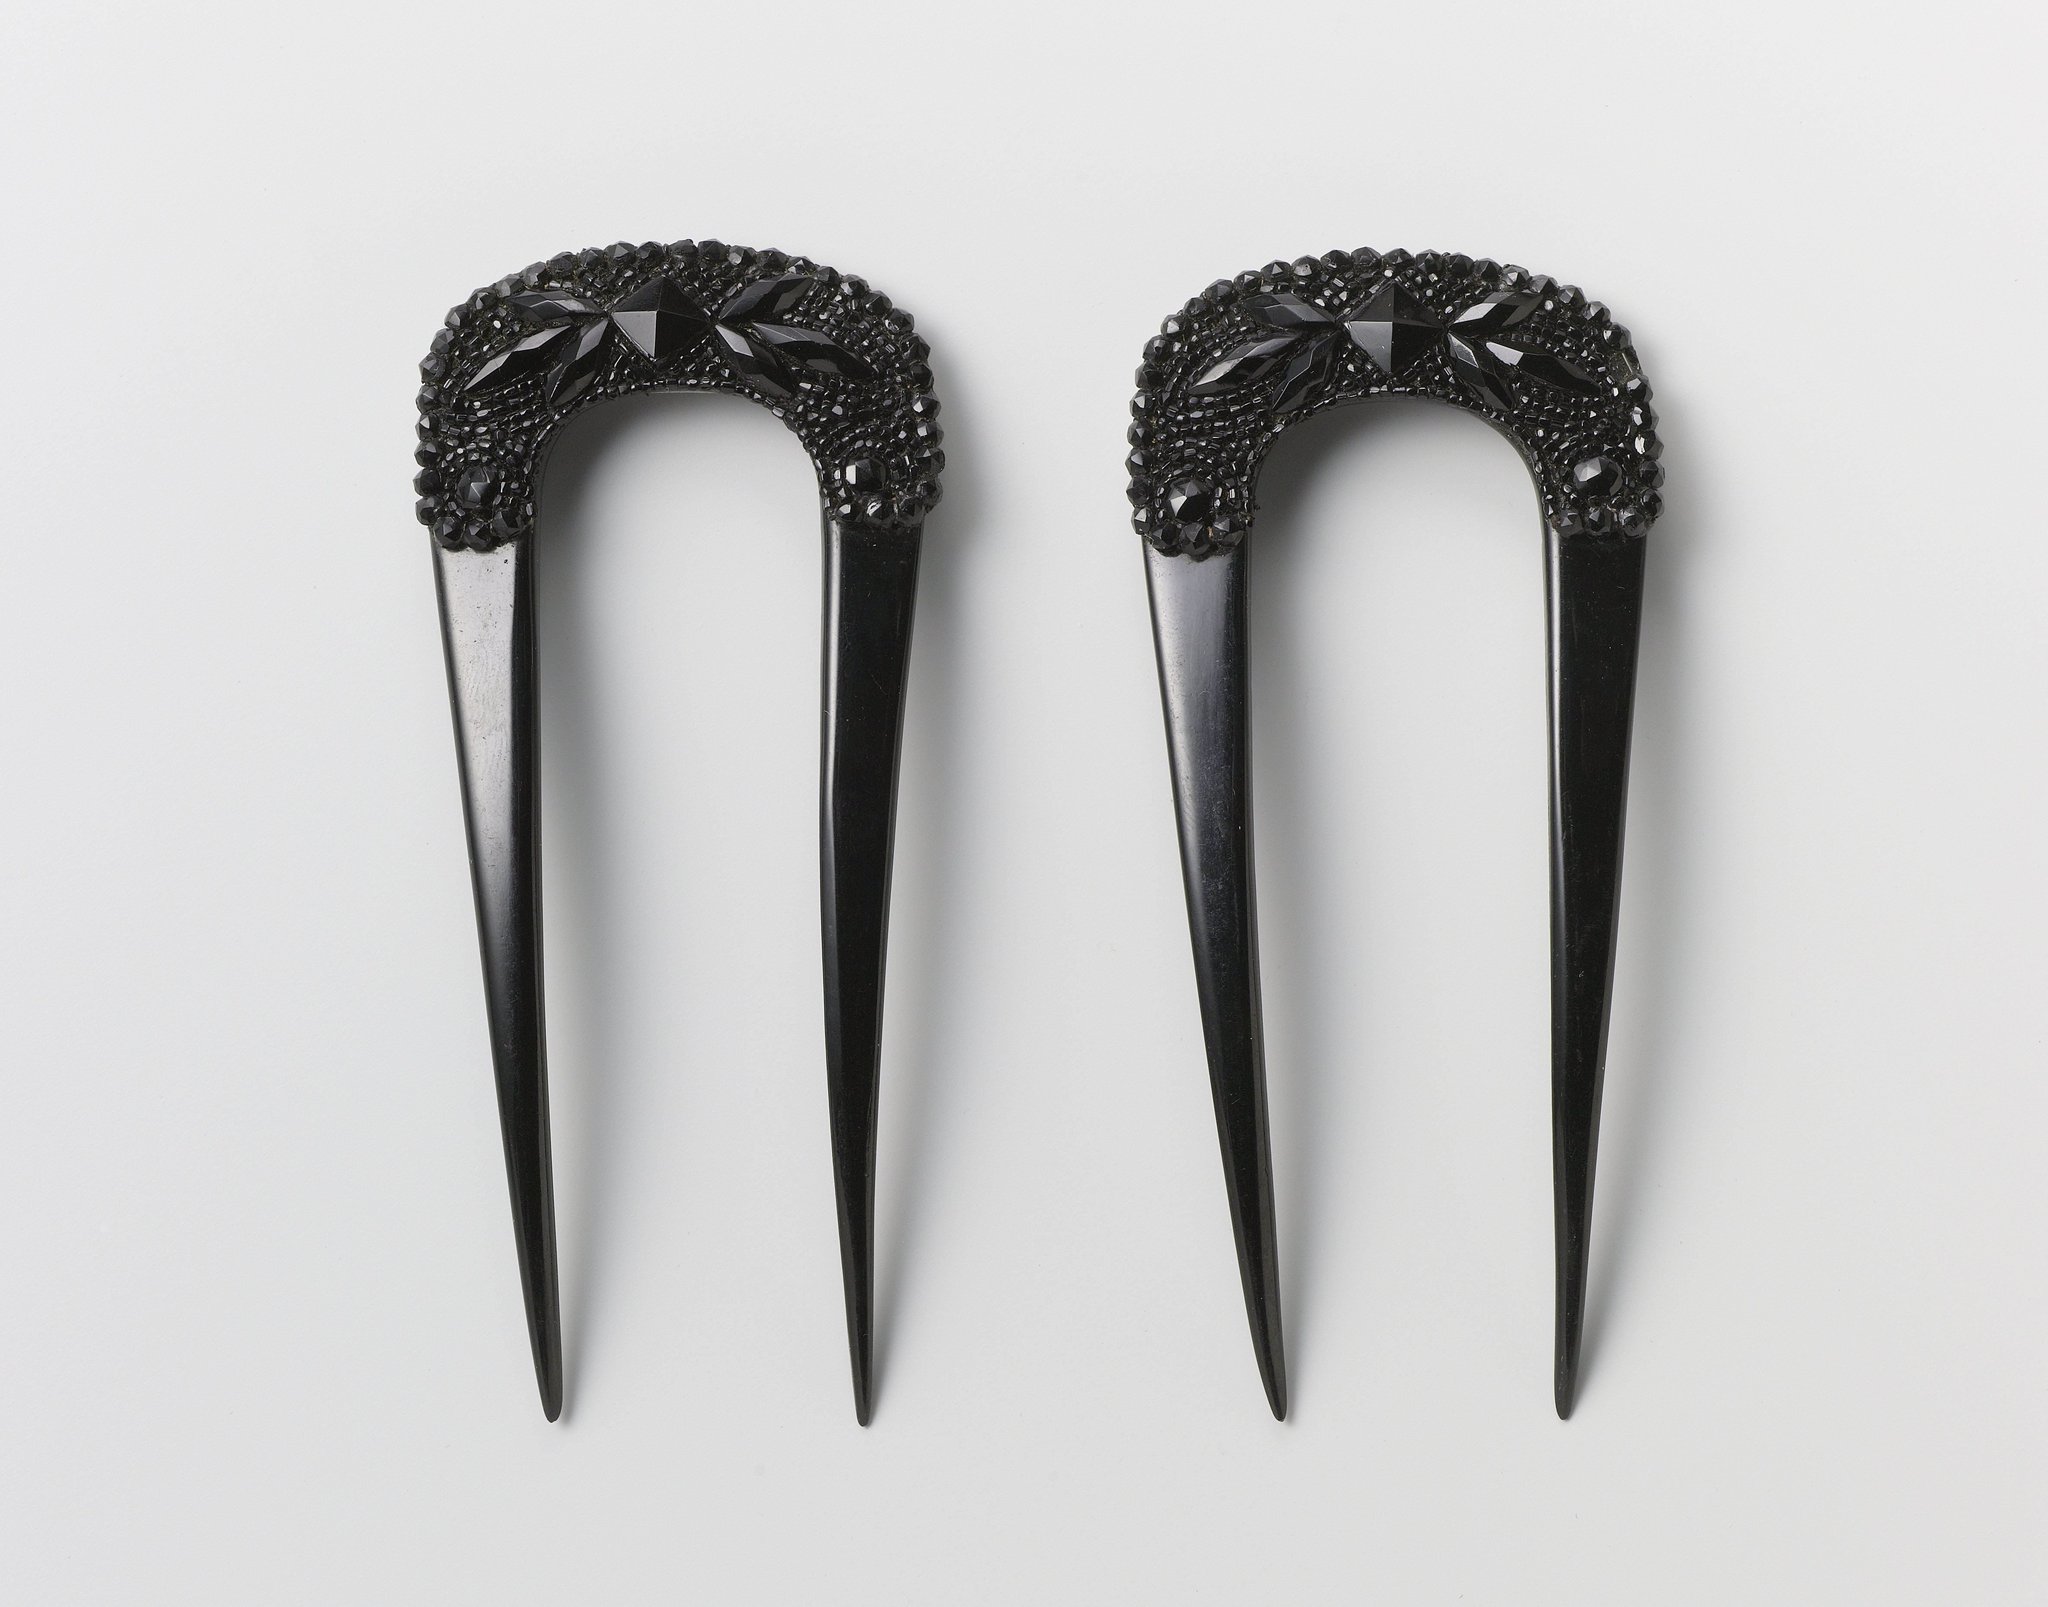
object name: comb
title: Haarkam van zwarte kunststof, U-vormig, waarvan de ronde rug met zwarte gitten is belegd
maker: Anonymous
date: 1900-1910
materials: jet, plastic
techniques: assembly, filing, polish, pressing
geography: netherlands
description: Paar sierhaarspelden met gitten belegd. Lang model, van twee tanden voorzien, verbonden door een brede boog. De boog heeft een gitten beleg met gerande grond, waarop een diamntknop tussen drie gerekte bladeren.